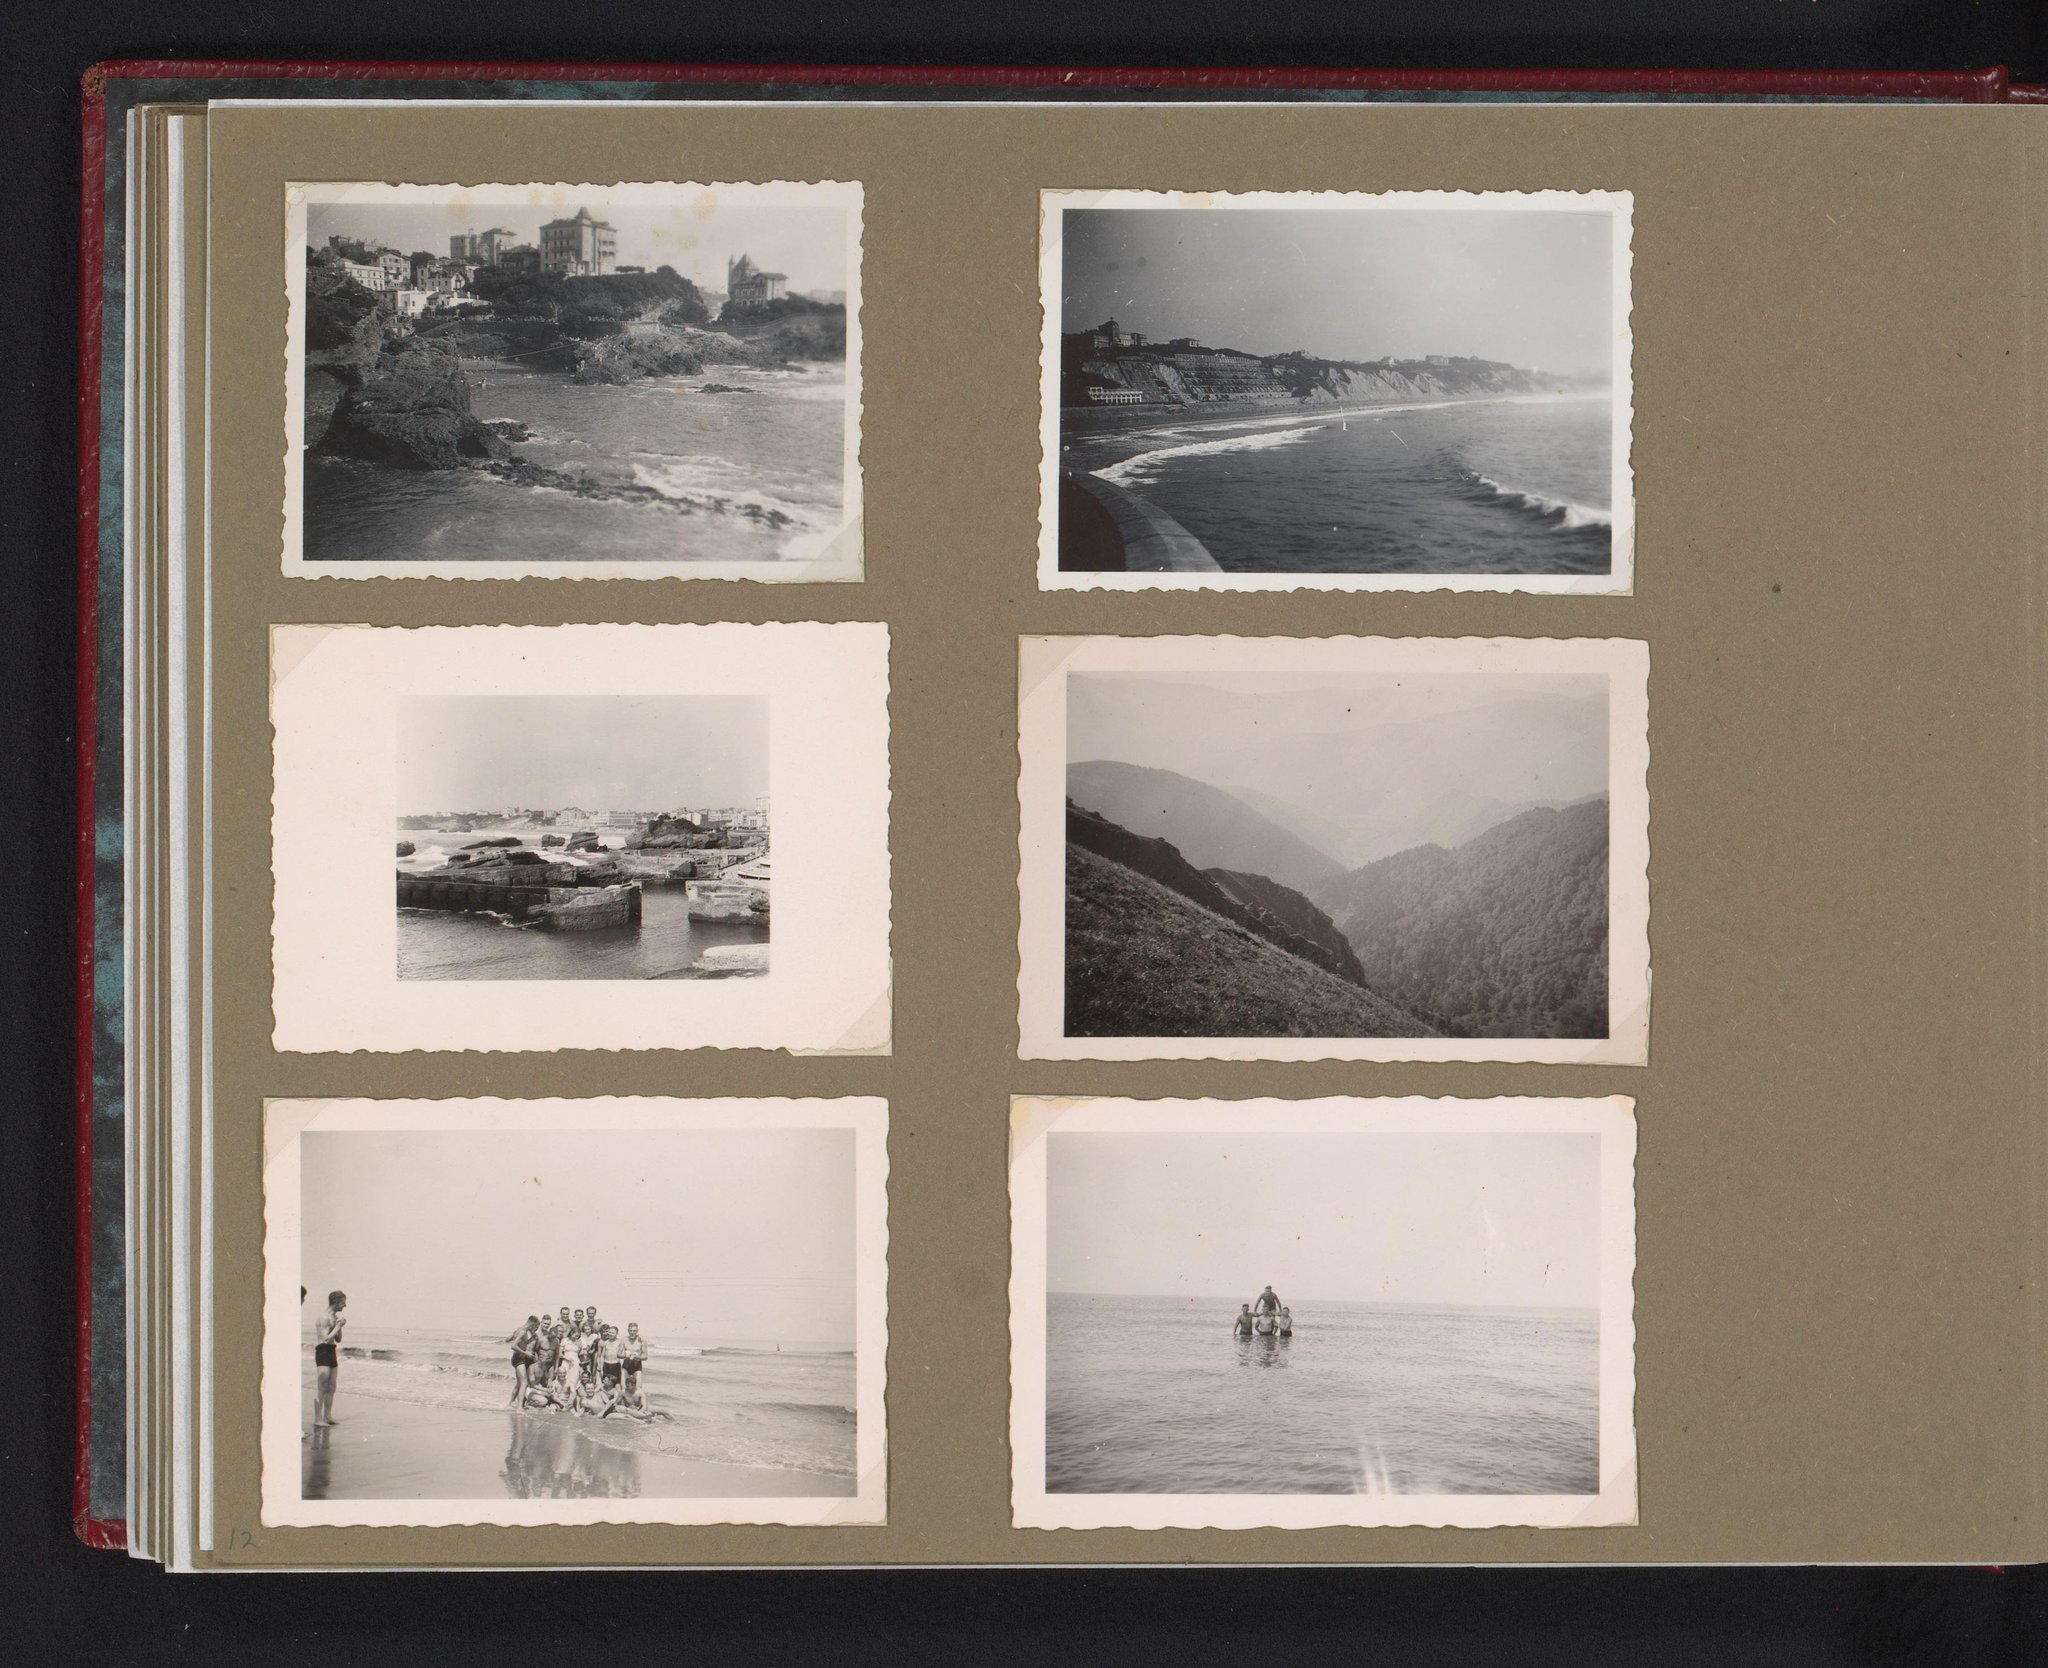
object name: album leaf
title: Kustlandschap en bergen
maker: Anonymous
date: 1940-1943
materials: paper, photographic support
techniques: gelatin silver print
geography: apeldoorn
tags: beach (as place of recreation), the company, the unit, the troop ~ military service, coast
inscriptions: name: ‘Fotohuis Van Ter Beek Apeldoorn’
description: Albumblad met zes foto's van de soldaten in hun vrije tijd aan het strand en een berglandschap. Onderdeel van het fotoalbum over soldaten van de Wehrmacht, ca. 1939-1943.